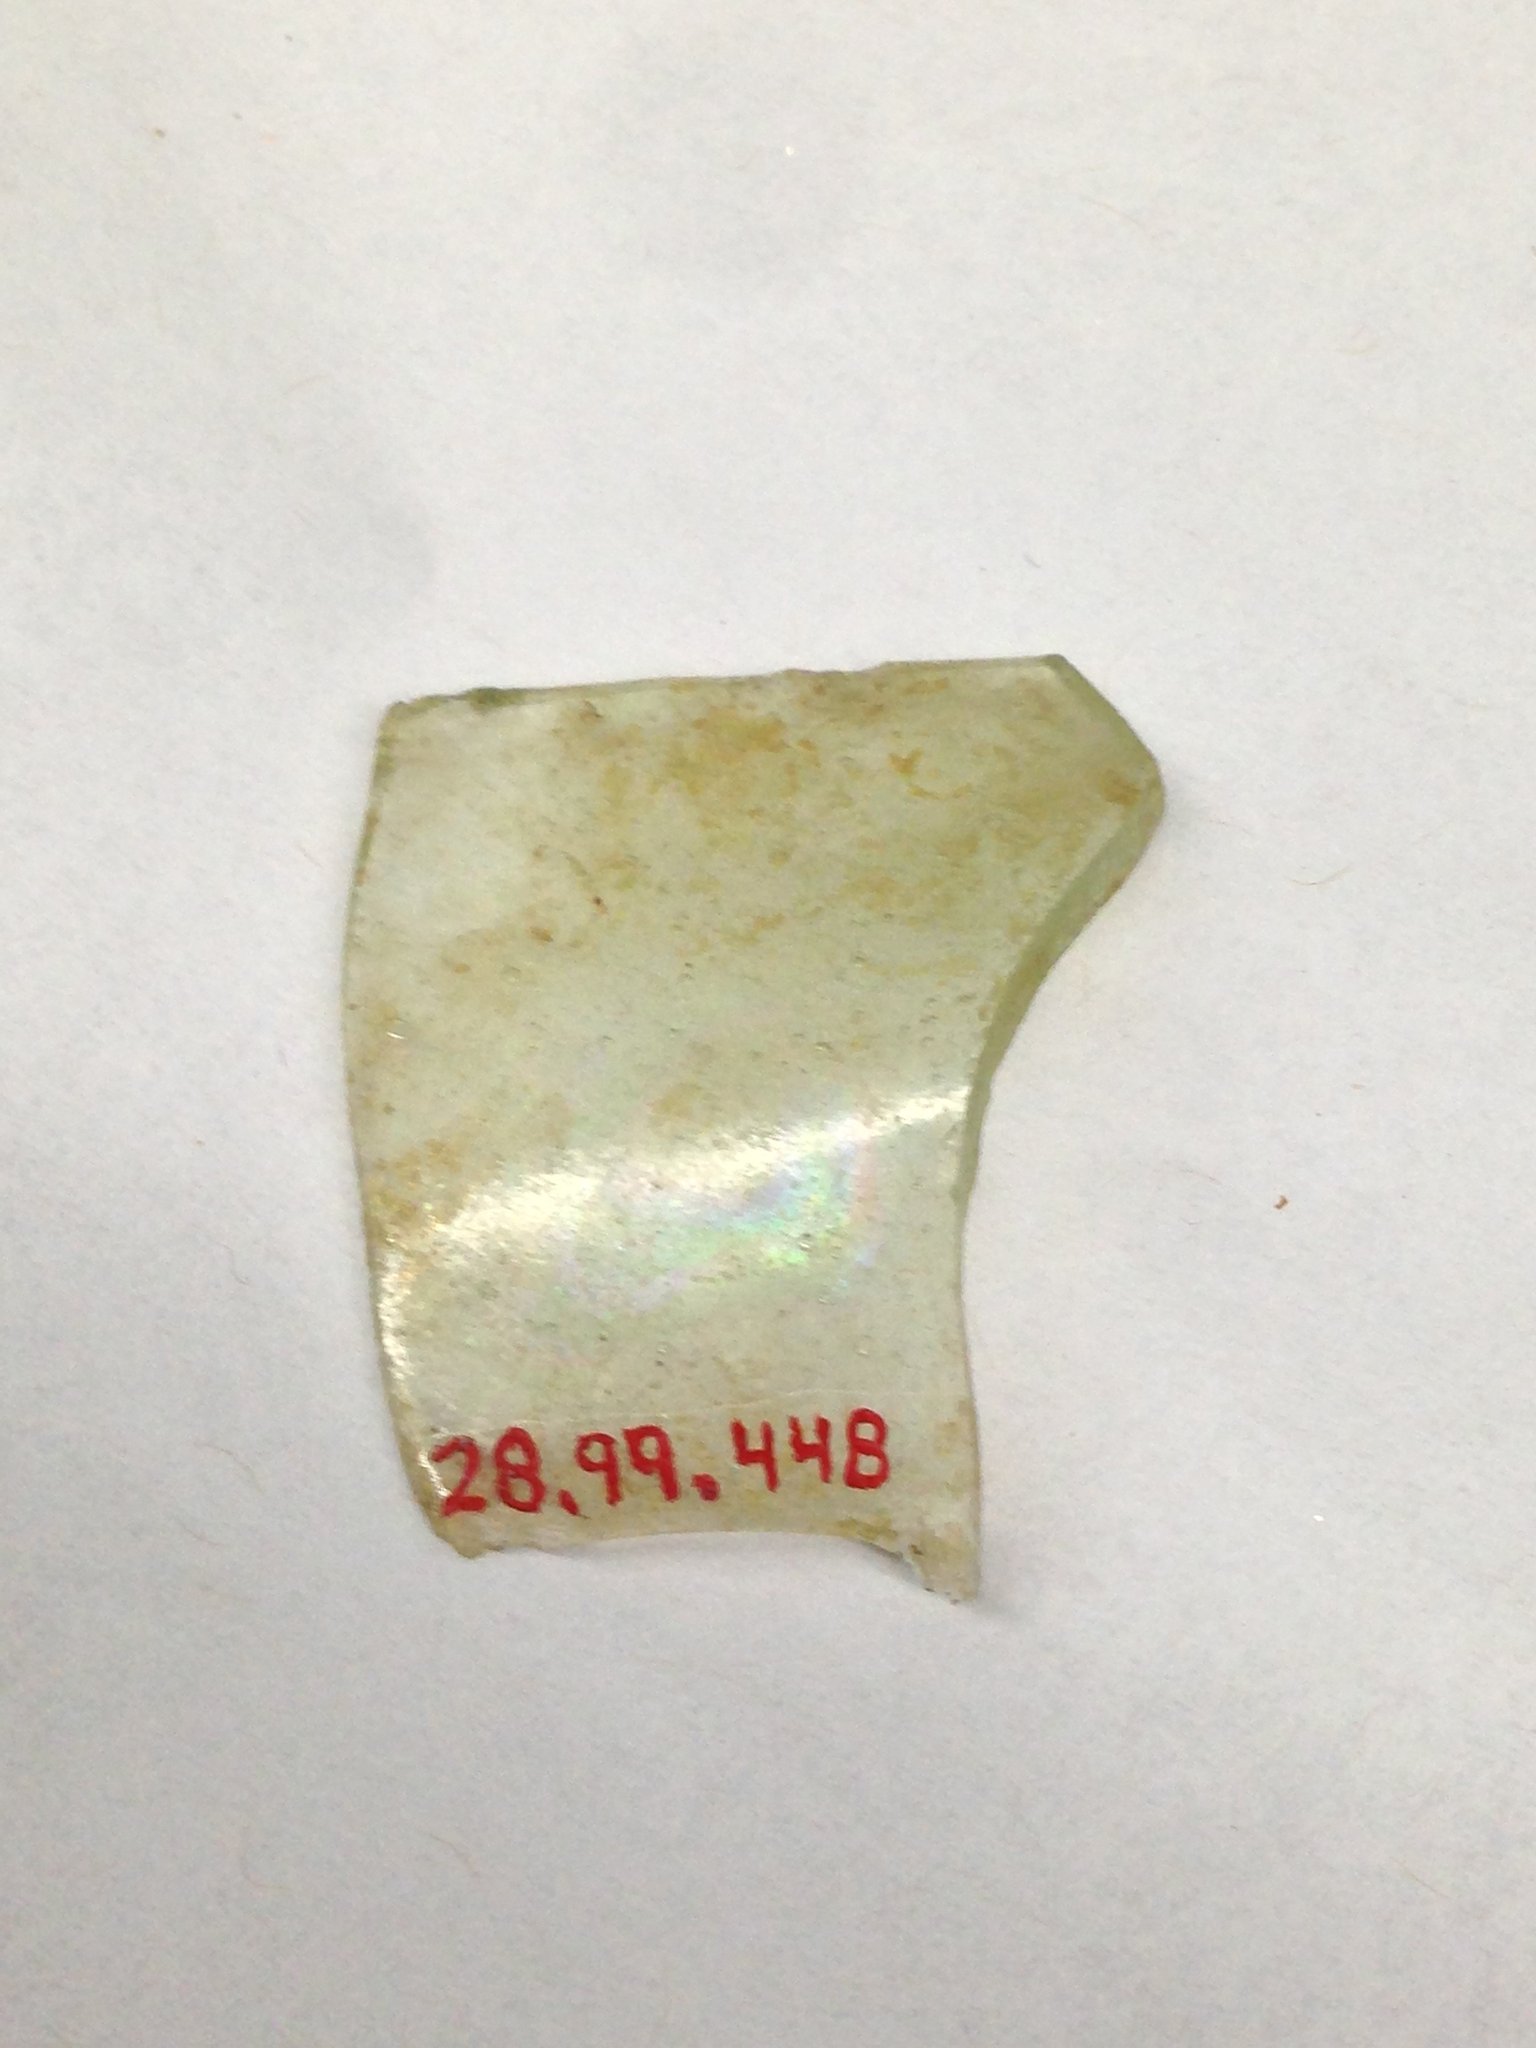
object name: fragment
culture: european or middle eastern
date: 1150-1250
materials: ceramic, glass